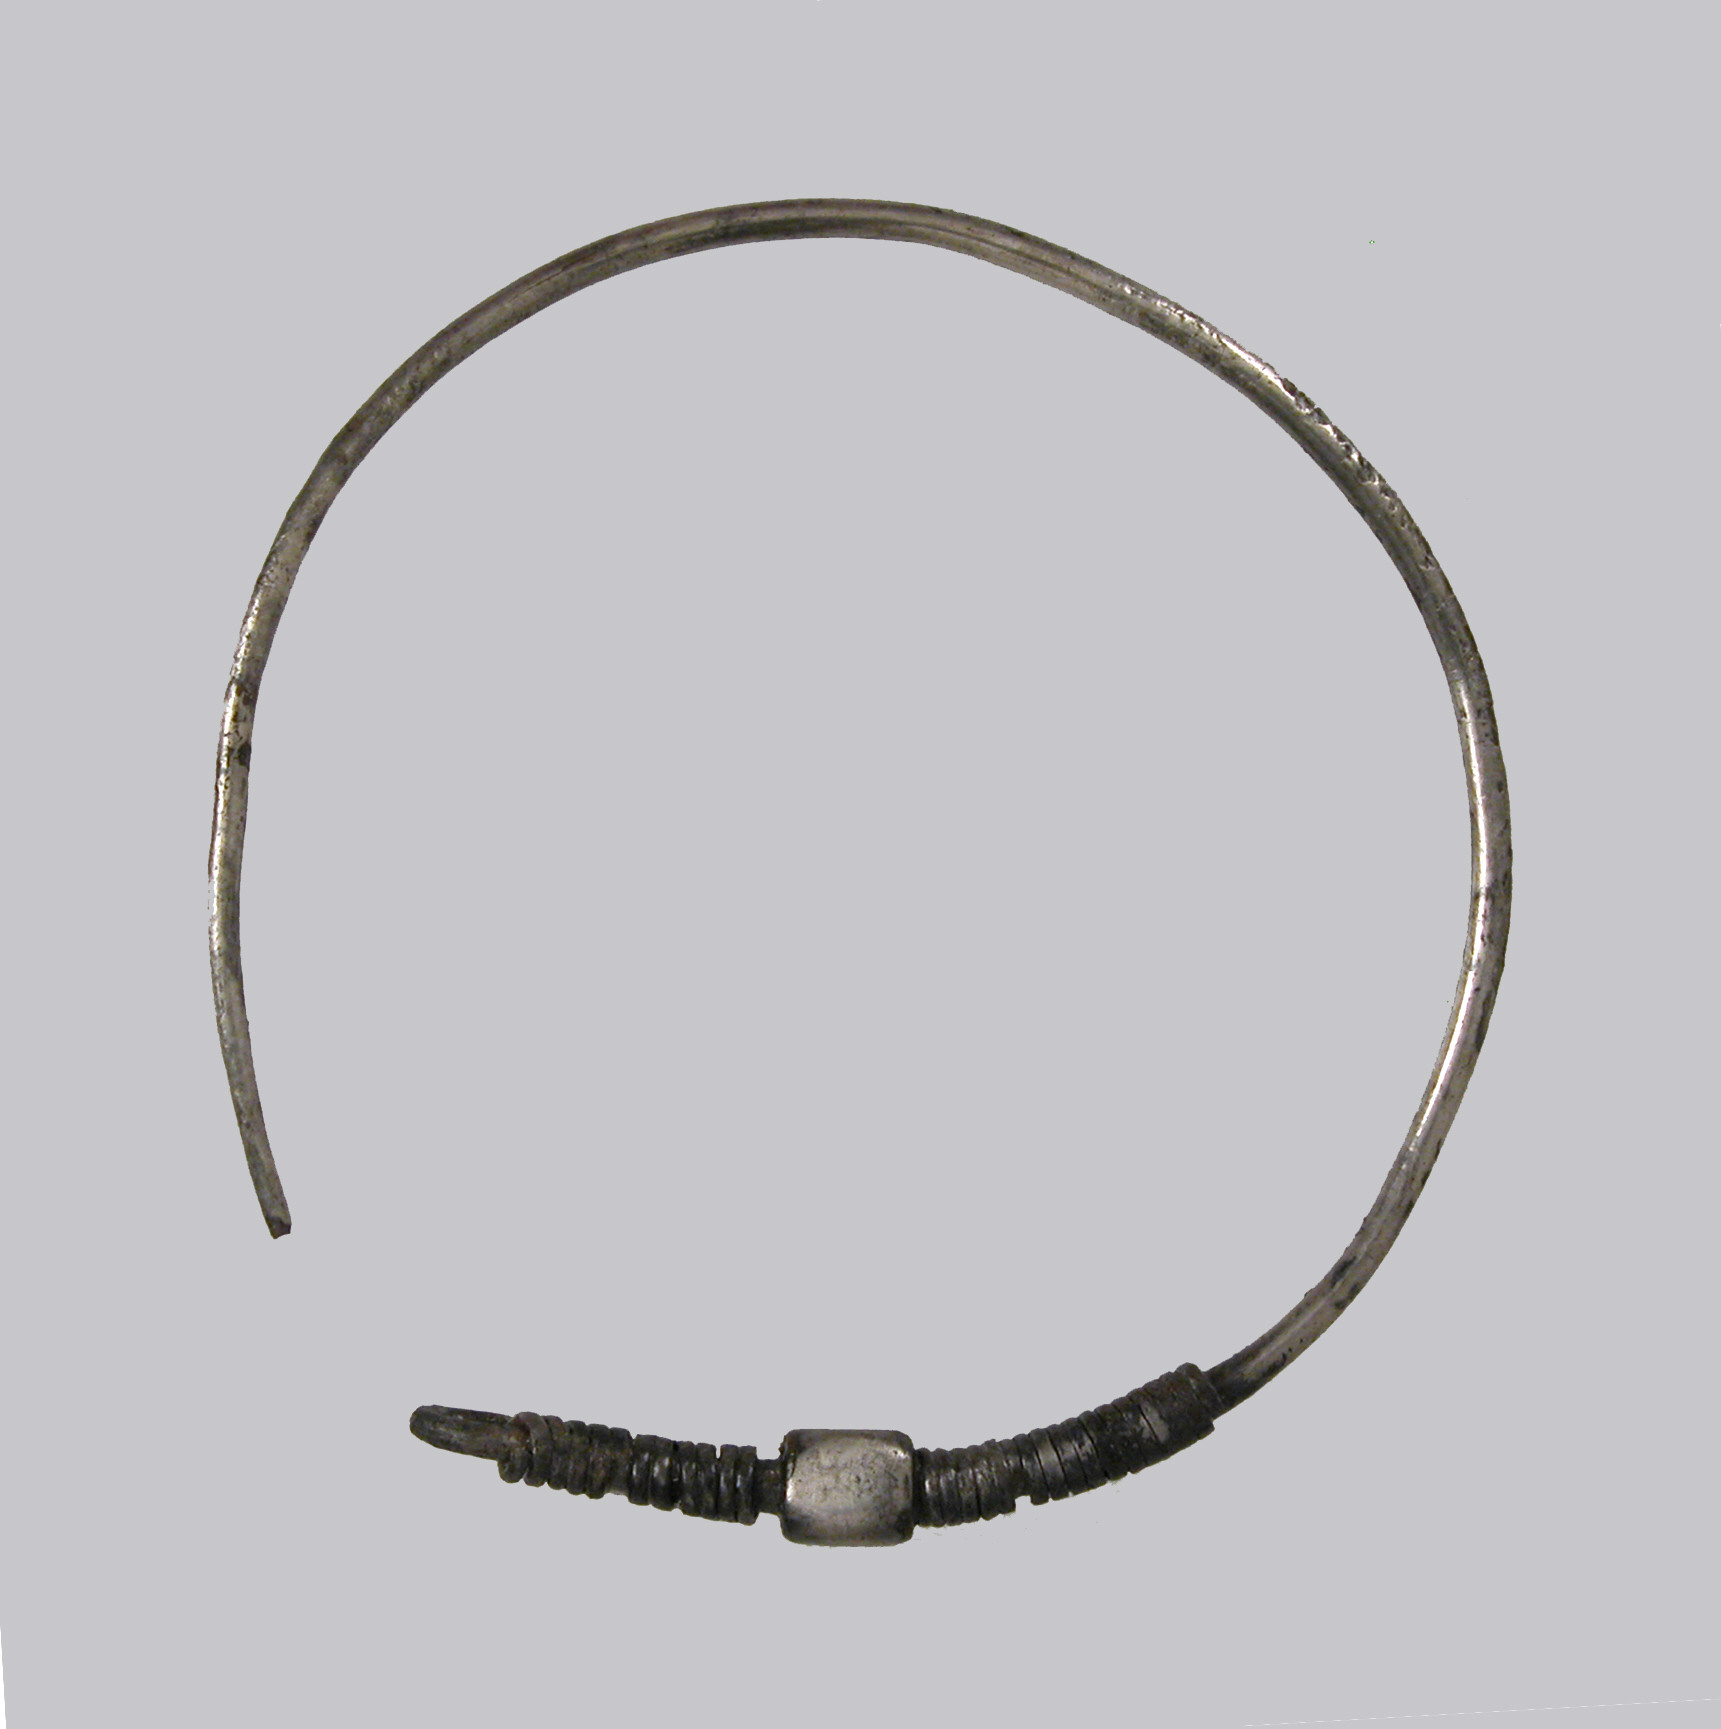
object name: earring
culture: frankish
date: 601-700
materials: silver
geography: germany